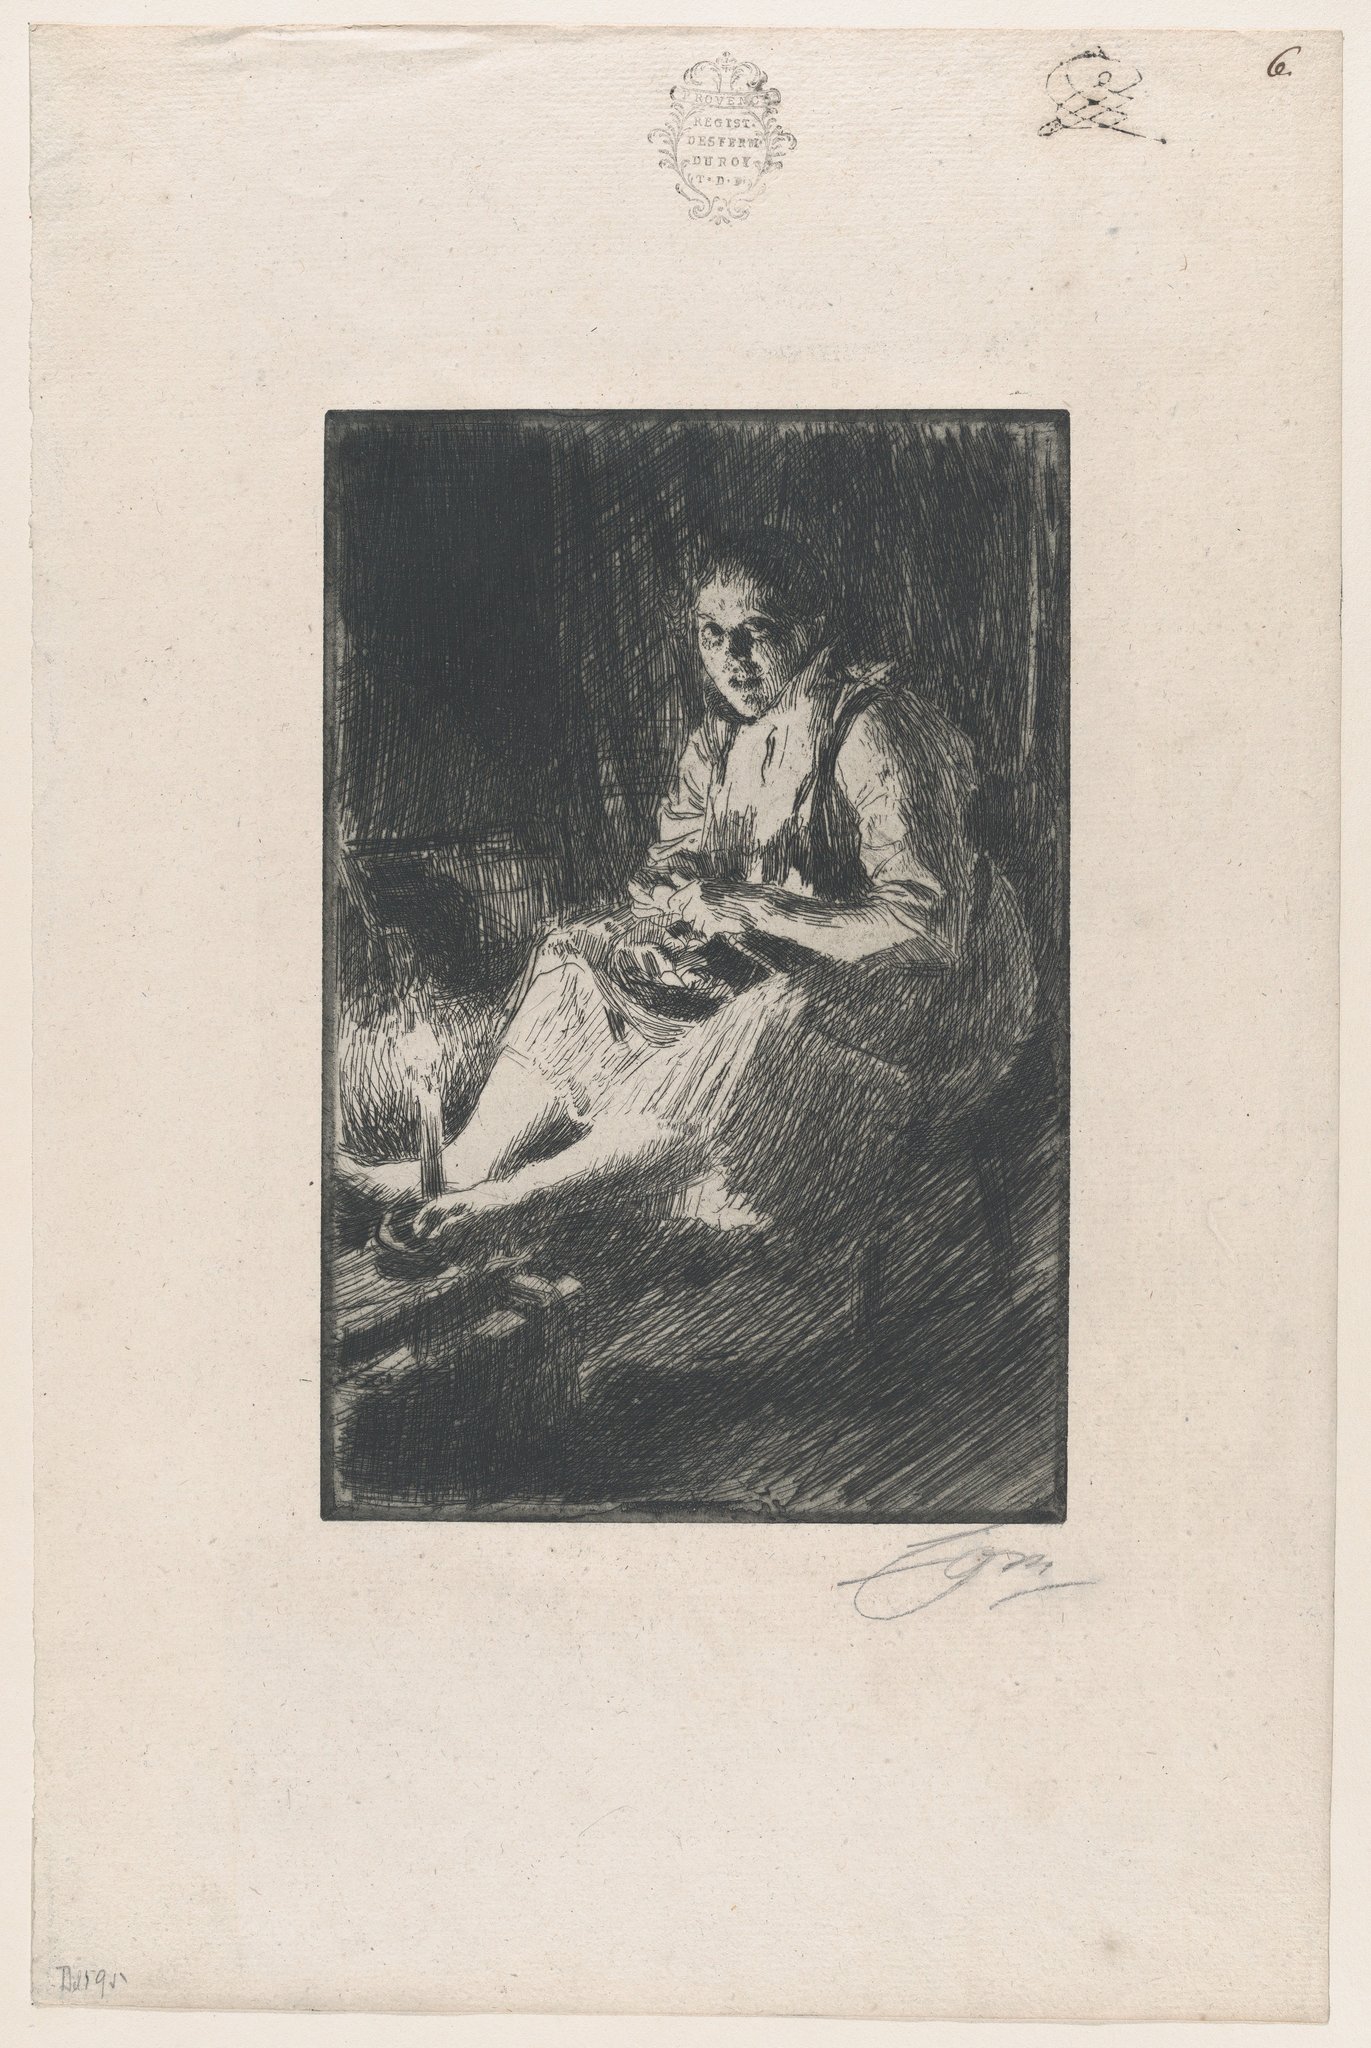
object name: print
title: Ida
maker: anders zorn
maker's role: artist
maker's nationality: swedish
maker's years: 1860-1920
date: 1905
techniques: etching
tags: women,candles